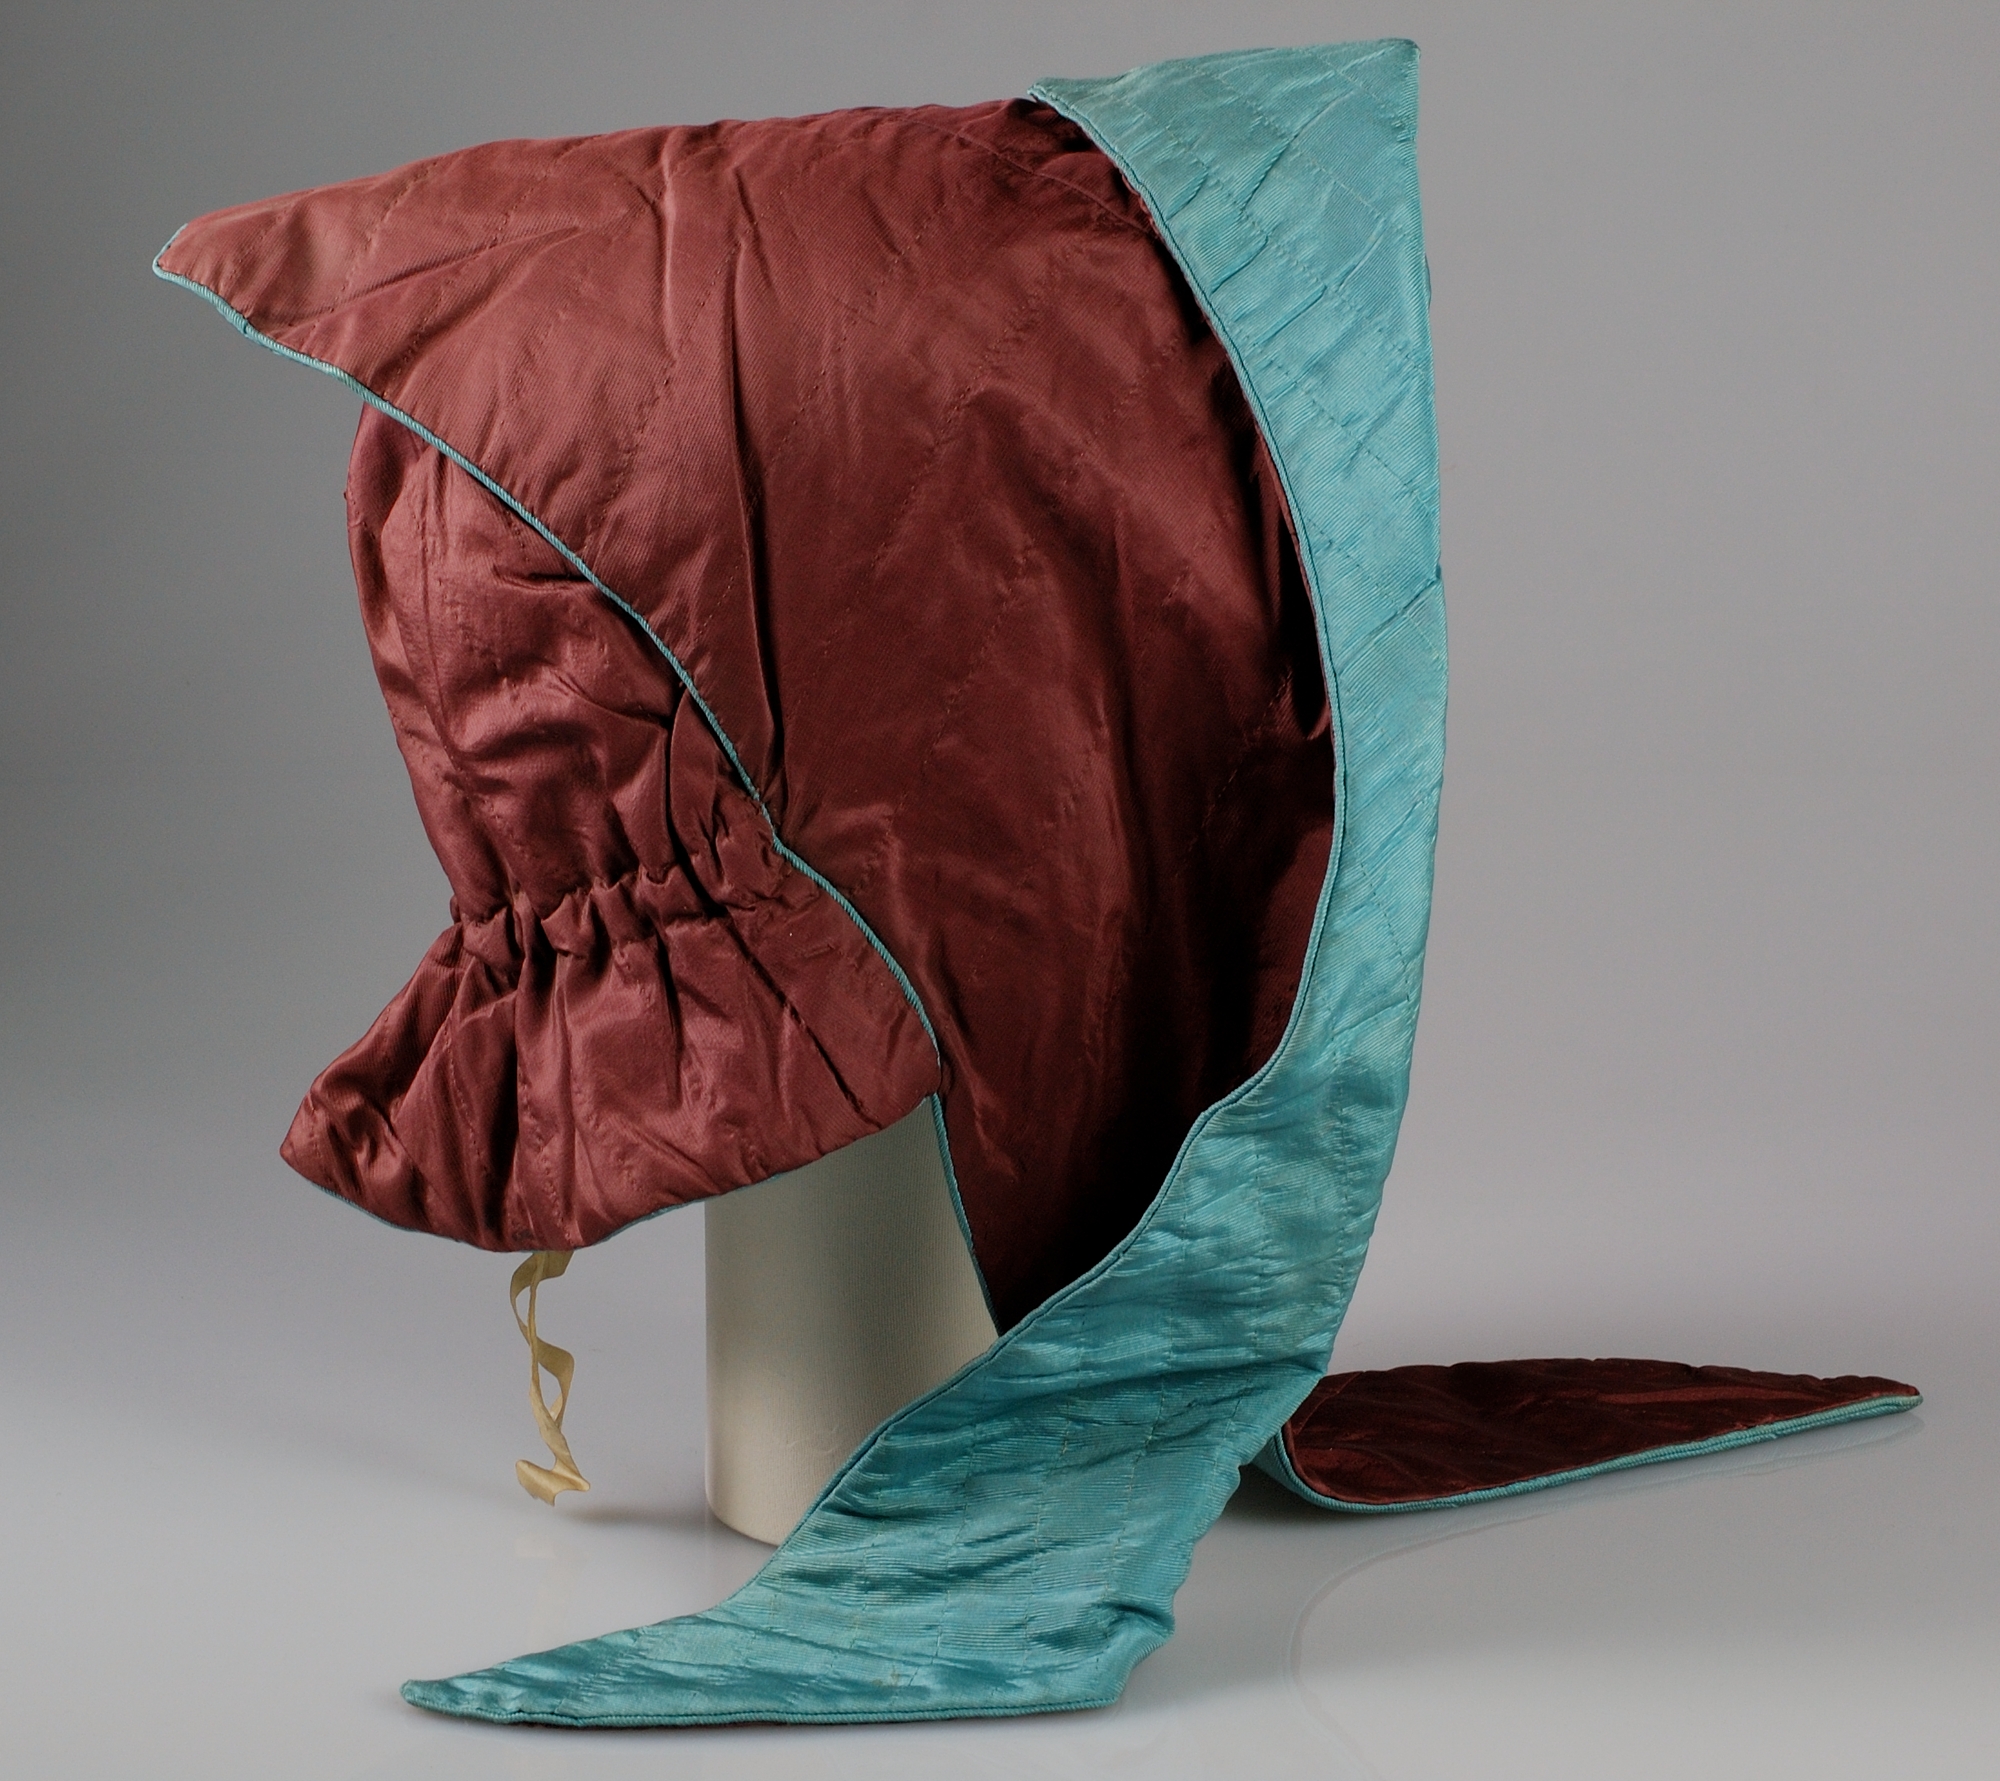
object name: evening bonnet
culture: american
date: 1870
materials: silk